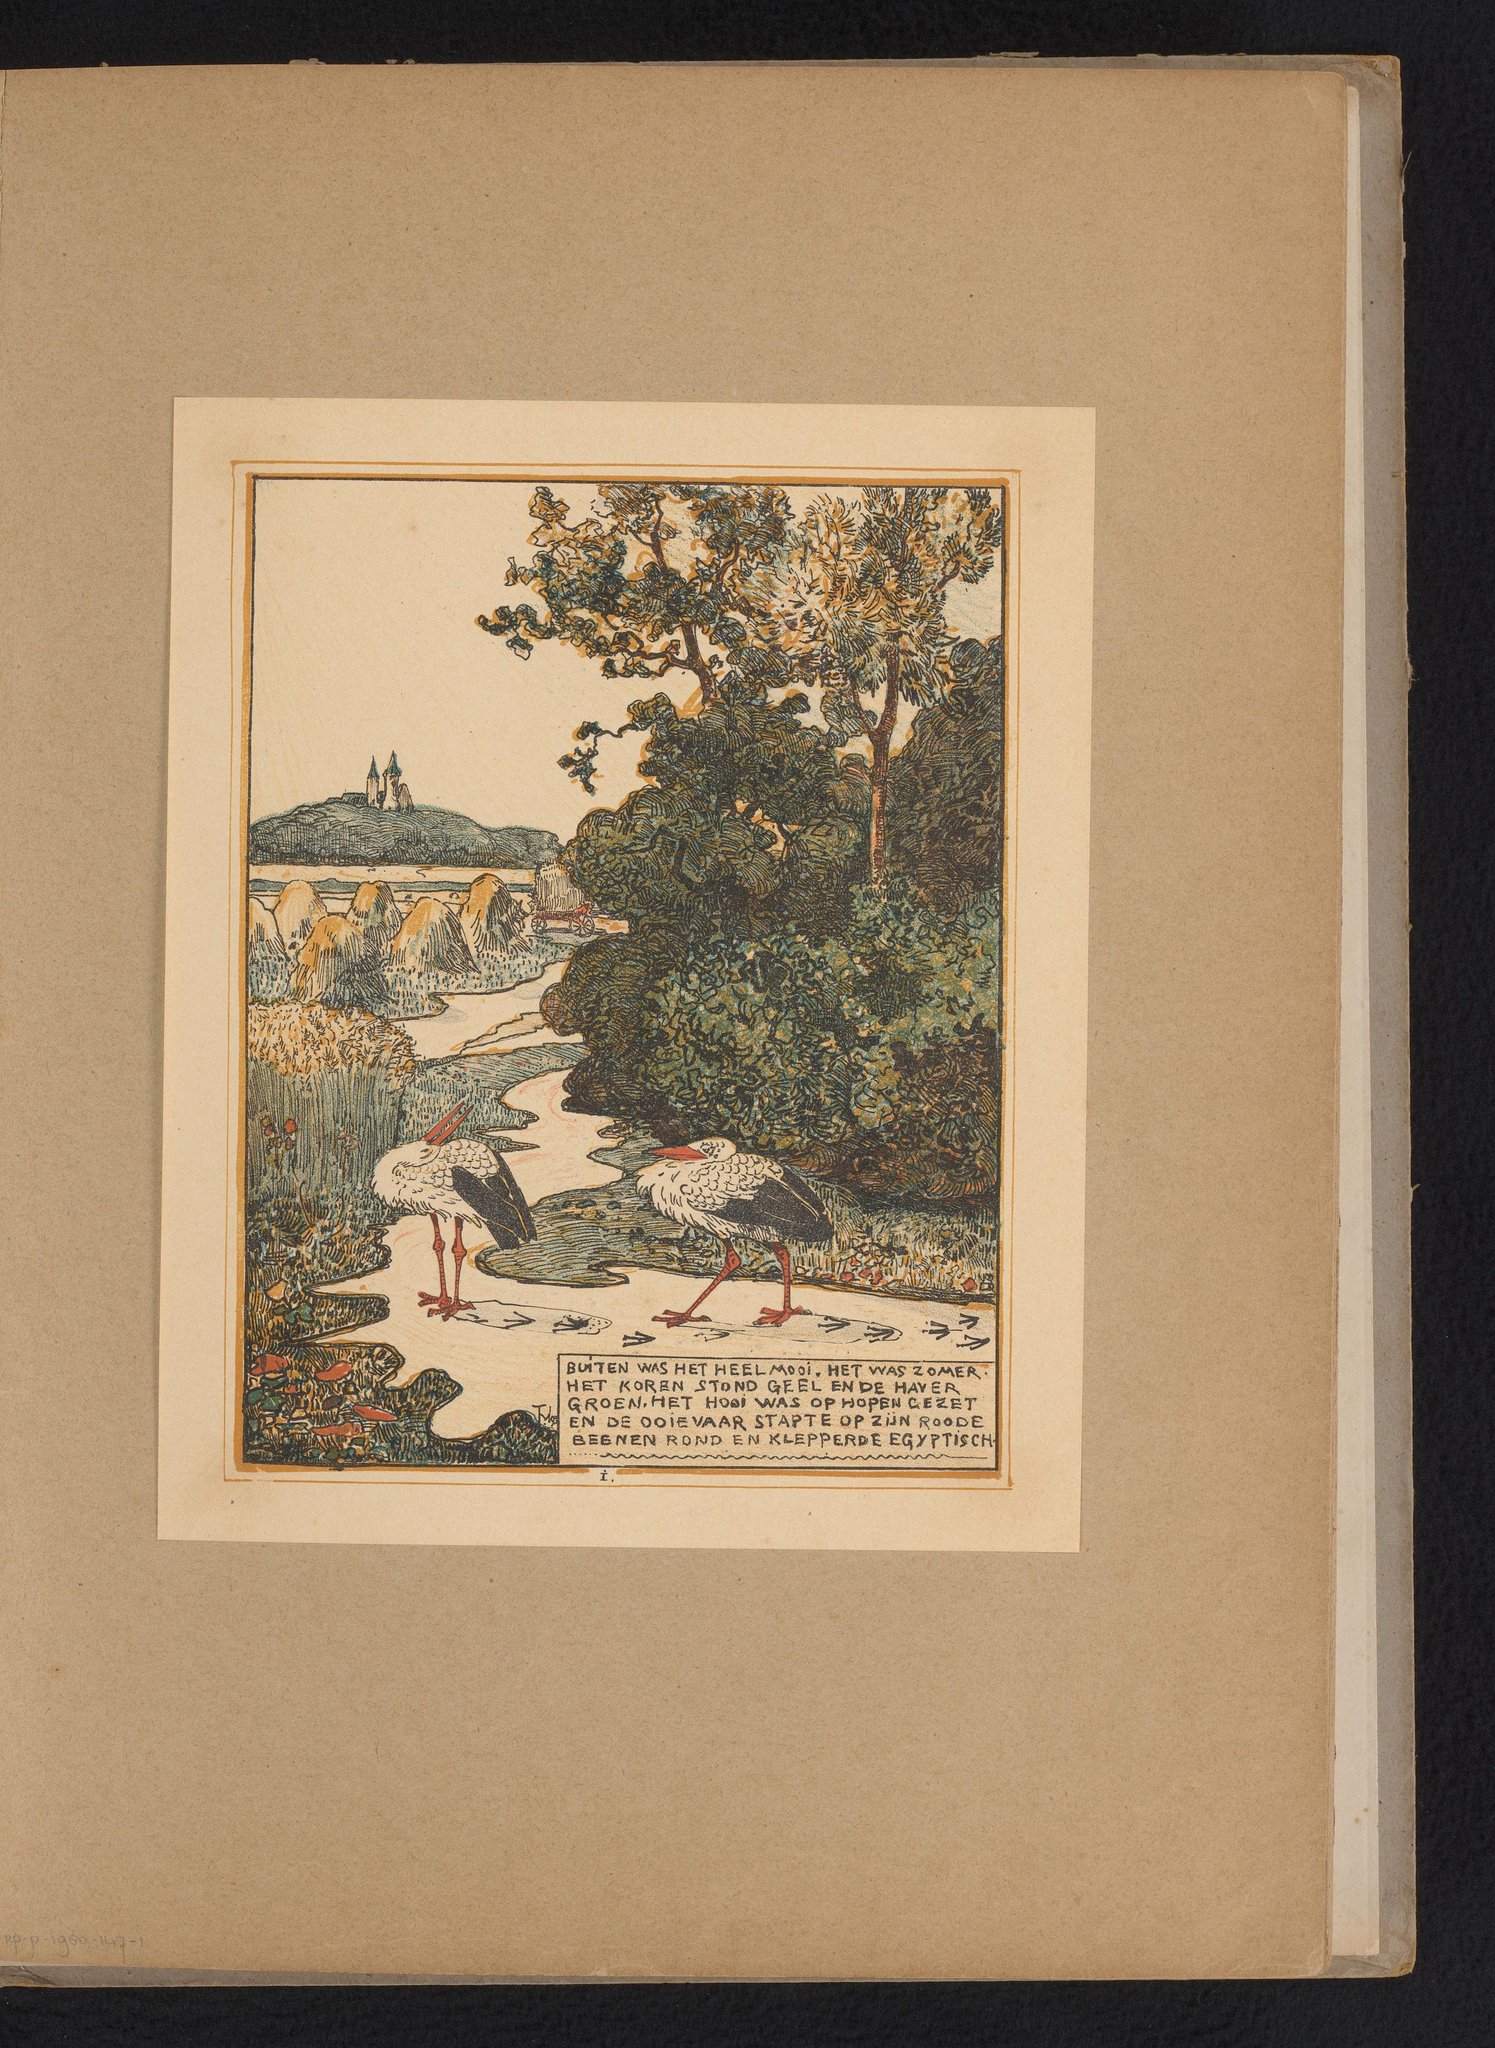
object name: print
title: Het leelijke jonge eendje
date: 1893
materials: paper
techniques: lithograph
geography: amsterdam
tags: shore-birds and wading-birds: stork, landscape with tower or castle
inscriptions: date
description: Deze prent maakt deel uit van een album.